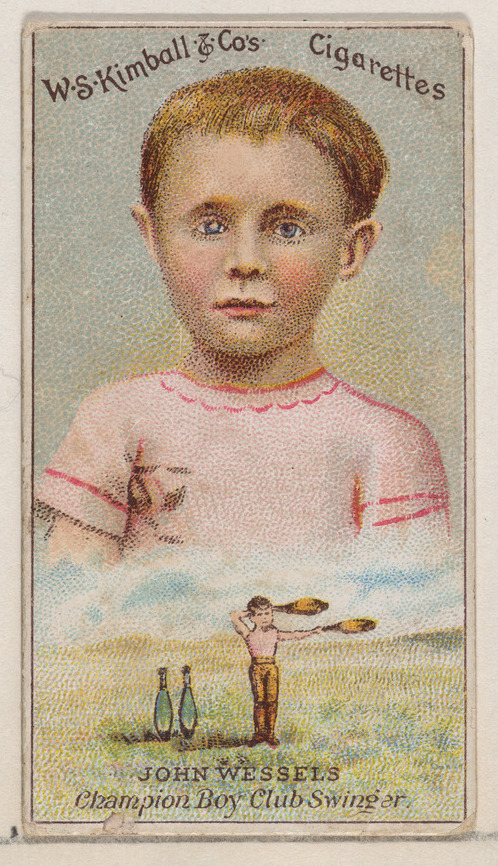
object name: print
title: John Wessels, Champion Boy Club Swinger, from the Champions of Games and Sports series (N184, Type 1) issued by W.S. Kimball & Co.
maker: w.s. kimball & co.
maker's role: publisher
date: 1887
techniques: color lithograph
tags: boys